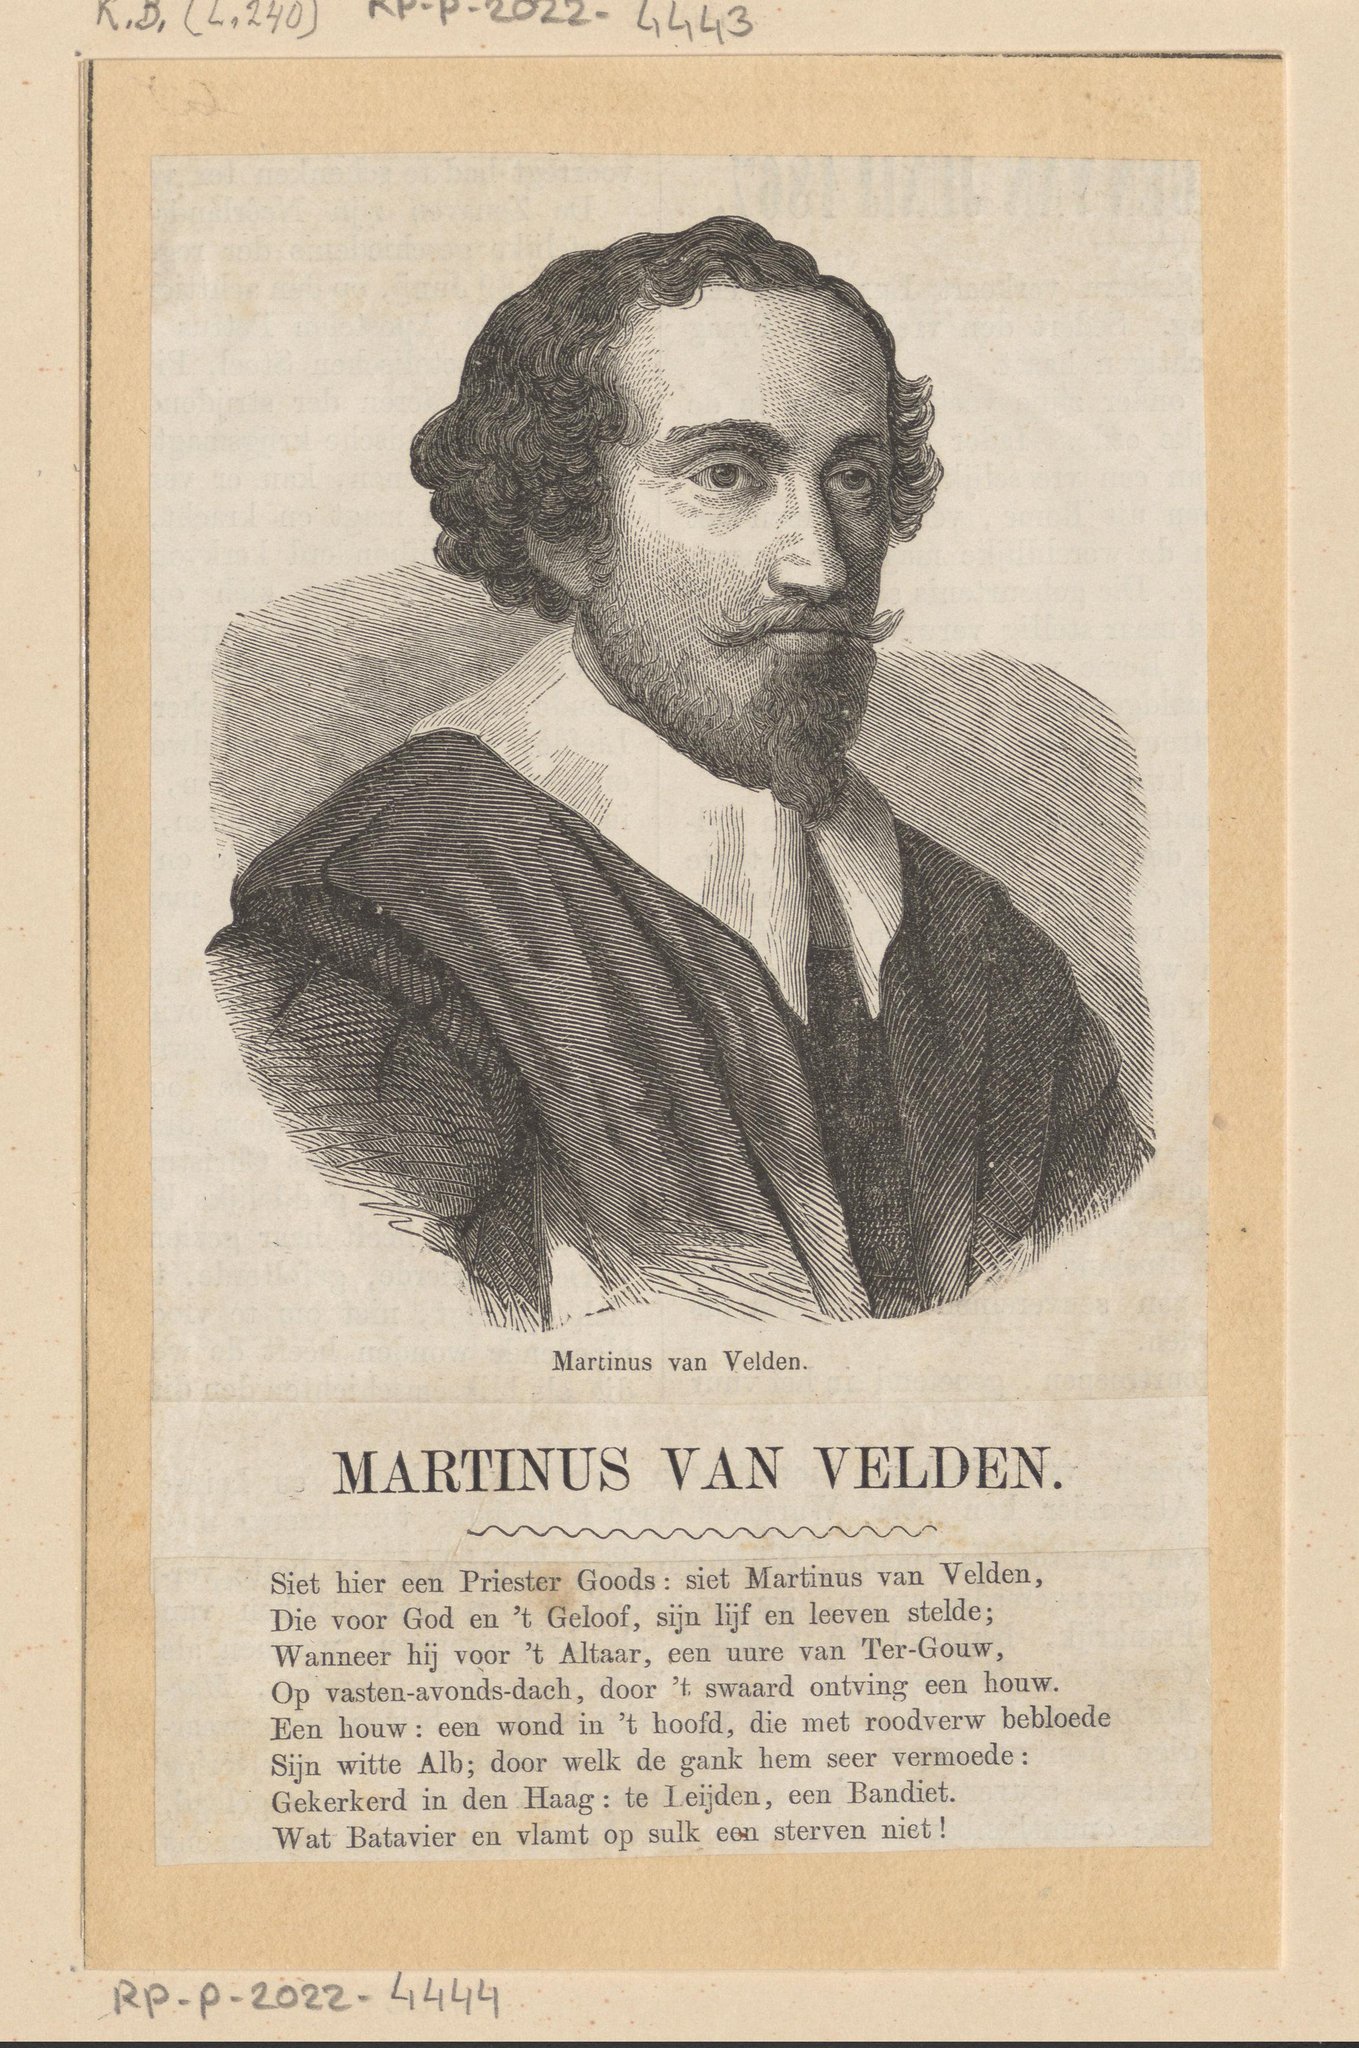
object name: print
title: Portret van Martinus van Velden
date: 1867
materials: paper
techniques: letterpress printing, engraving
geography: netherlands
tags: priest (roman catholic), historical persons, martyr(s) (often with palm-branches)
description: Onder het portret is een achtregelig vers in het Nederlands geplakt.